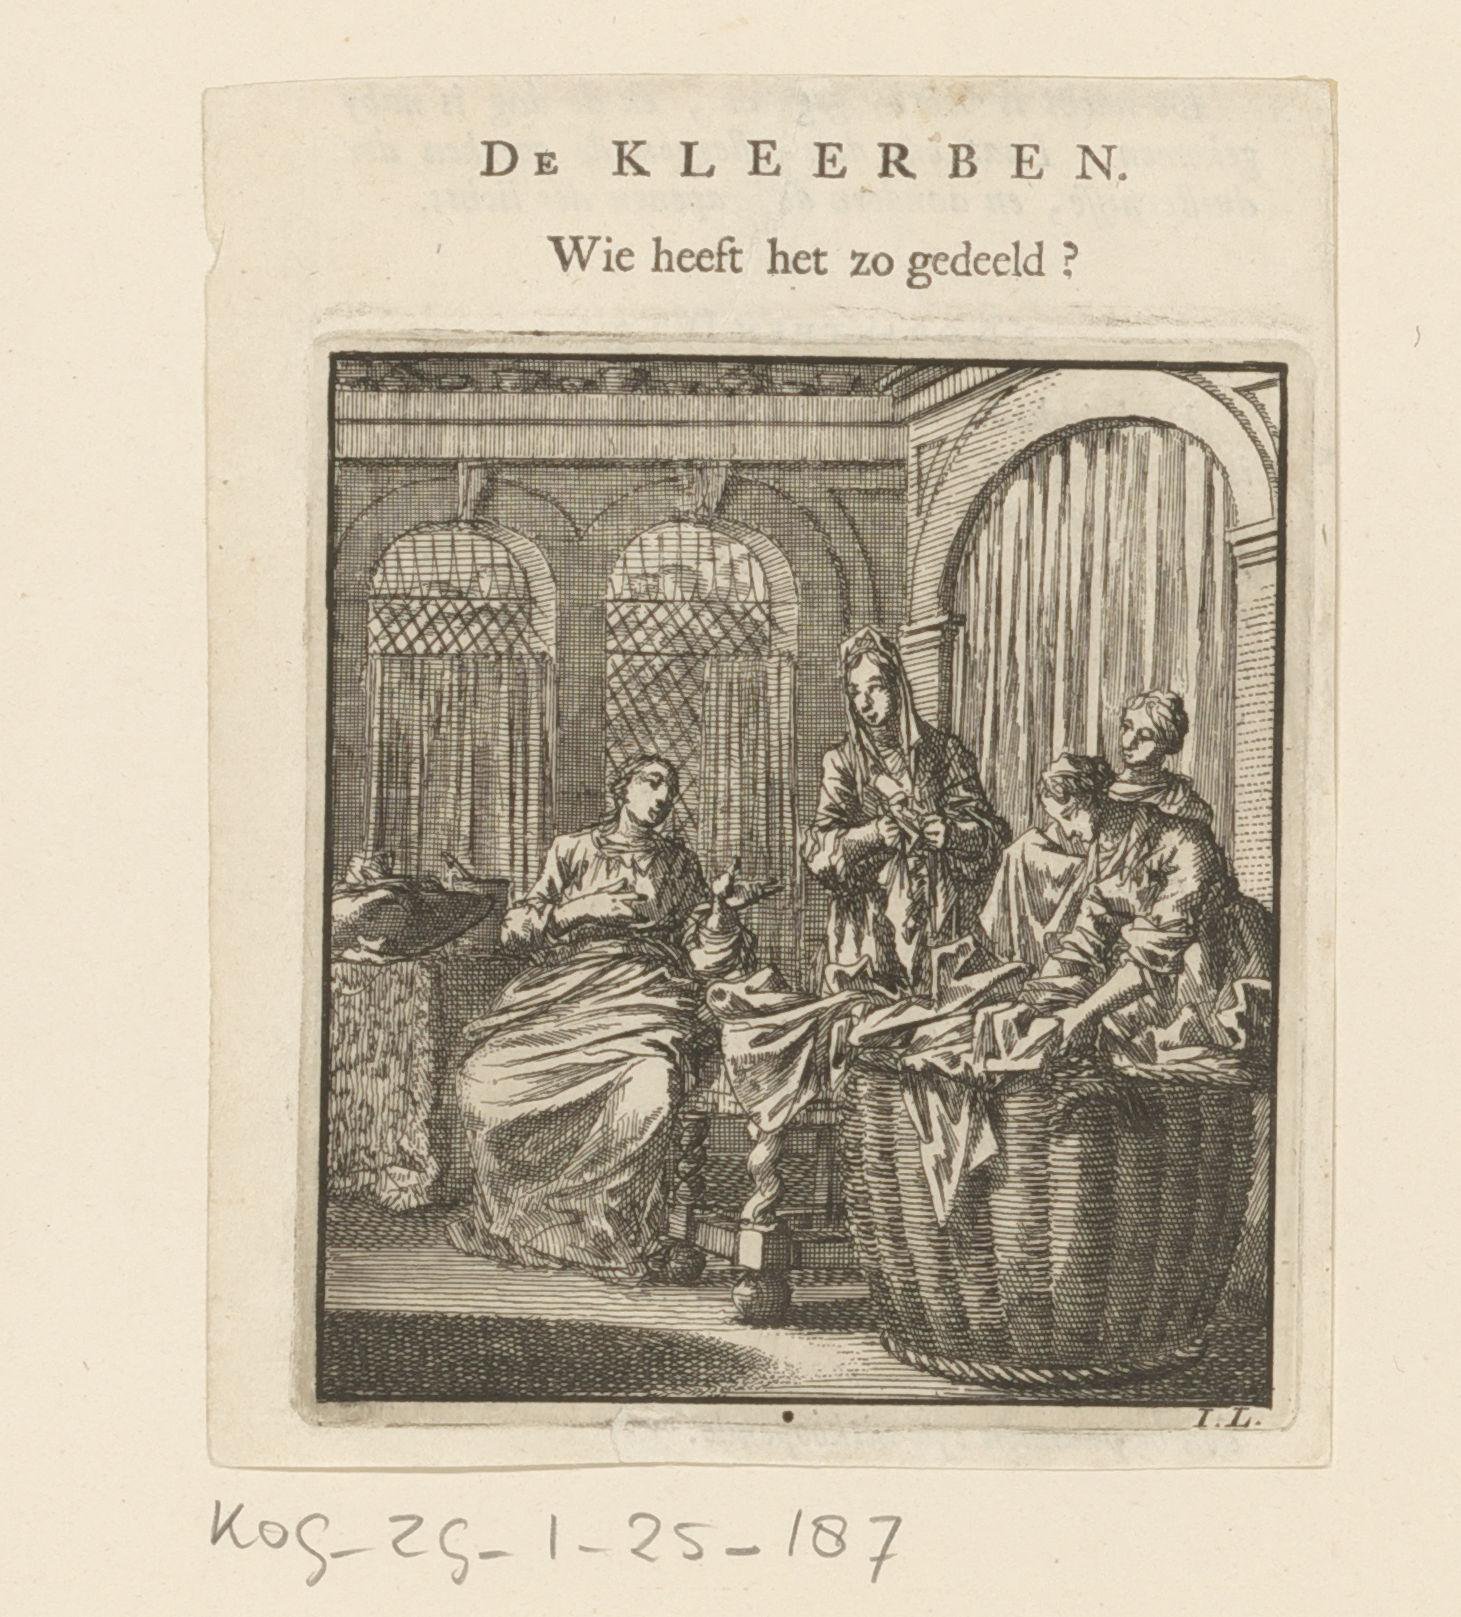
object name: book illustration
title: De Kleerben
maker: jan luyken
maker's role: draughtsman, print maker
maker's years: 1649-1712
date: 1711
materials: paper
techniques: etching, letterpress printing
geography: amsterdam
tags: container made of plant material other than wood: basket, wash house, home laundry, laundry room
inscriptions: collector's mark: Lugt 1641, stamp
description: Prent uit: Luyken, Jan. Het leerzaam huisraad, vertoond in vyftig konstige figuuren, met godlyke spreuken en stichtelyke verzen. Amsterdam: weduwe Pieter Arentsz. II en Cornelis van der Sys, 1711, p. 114.